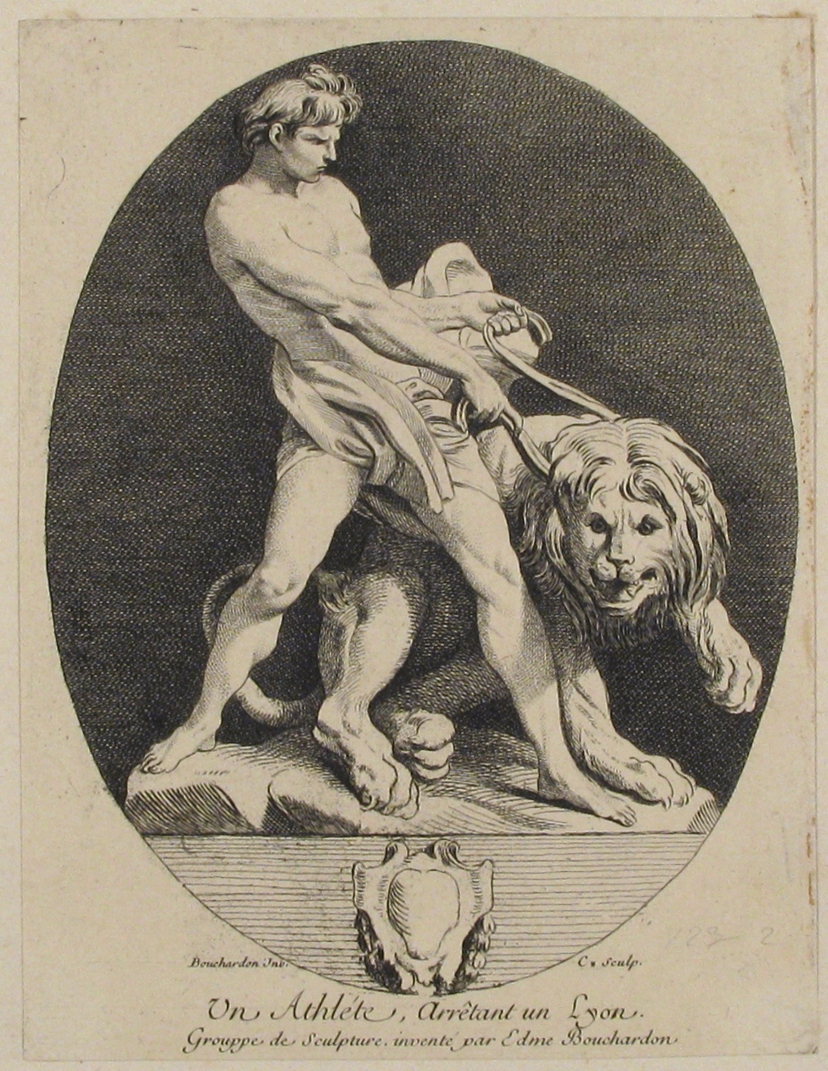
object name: print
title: An Athlete Stopping a Lion, from "Group of Subjects Drawn From Antiquity"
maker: anne claude philippe de tubières, comte de caylus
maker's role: artist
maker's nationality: french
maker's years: 1692-1765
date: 1737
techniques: etching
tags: men,lions,athletes